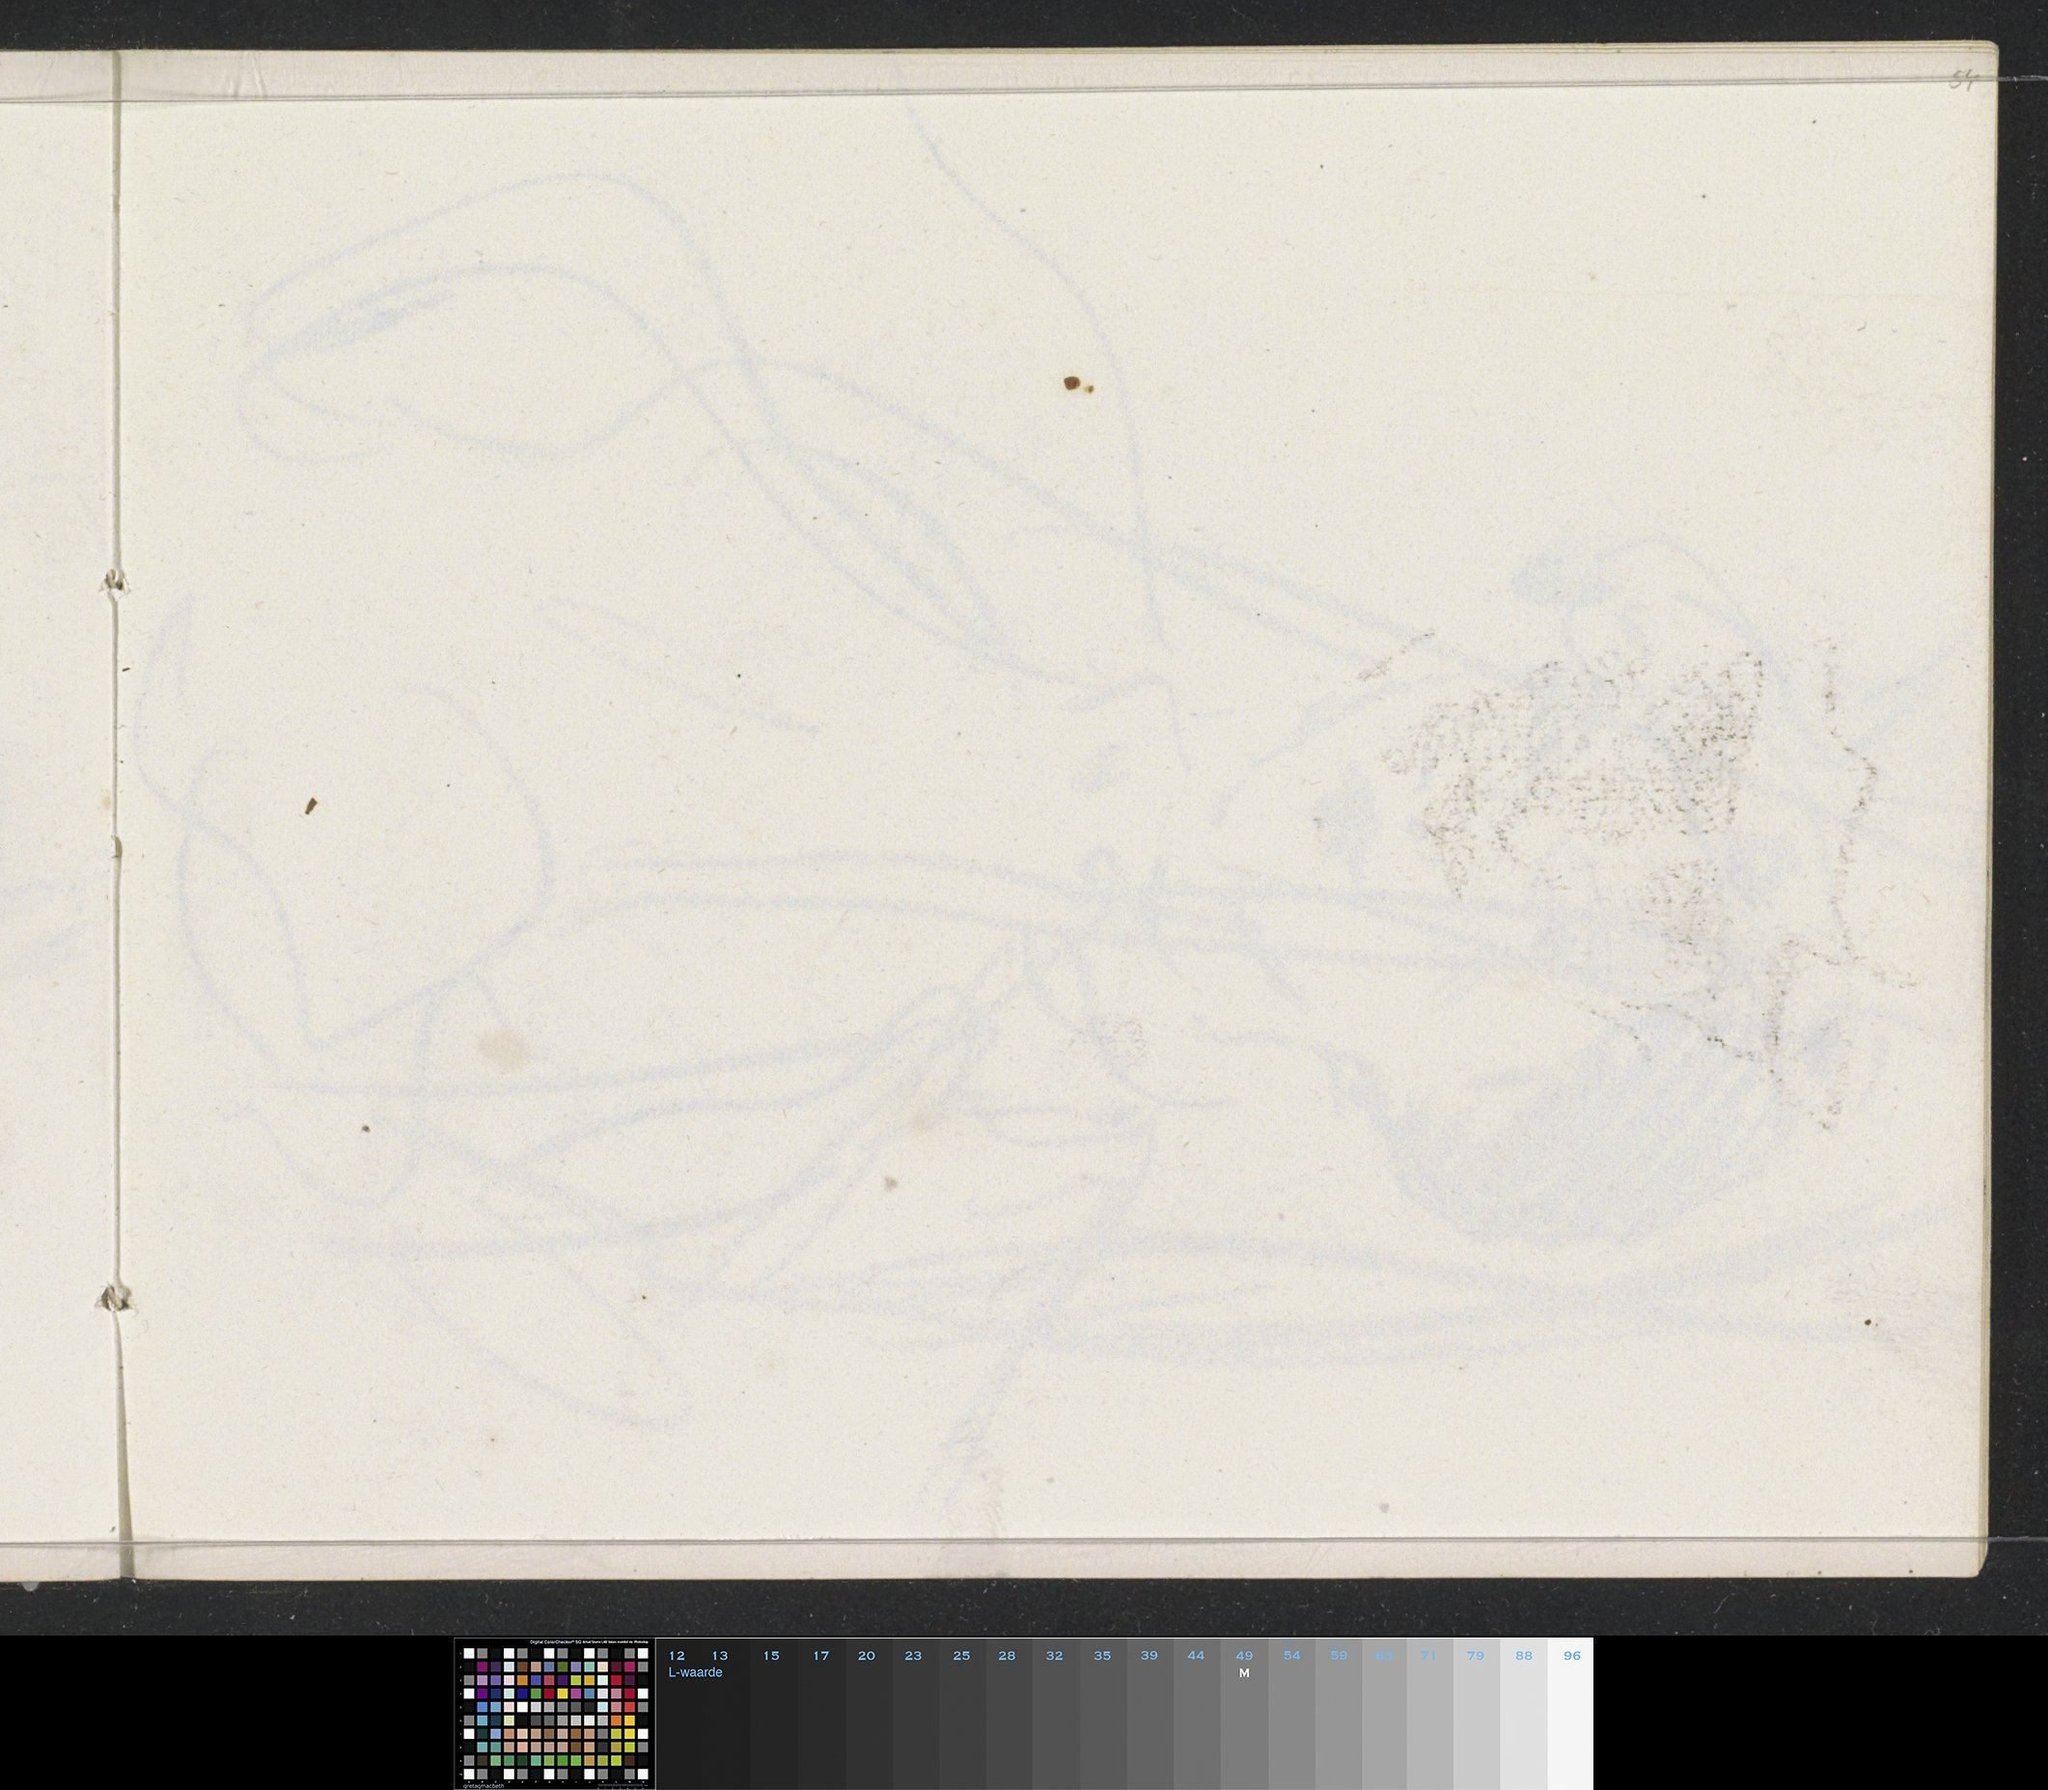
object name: sketchbook leaf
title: Abklatsch van de krijttekening op pagina 53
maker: isaac israels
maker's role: draughtsman, painter, print maker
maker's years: 1865-1934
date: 1875-1934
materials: paper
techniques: printmaking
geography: the hague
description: Pagina 54 uit schetsboek XLIII met 61 pagina's.